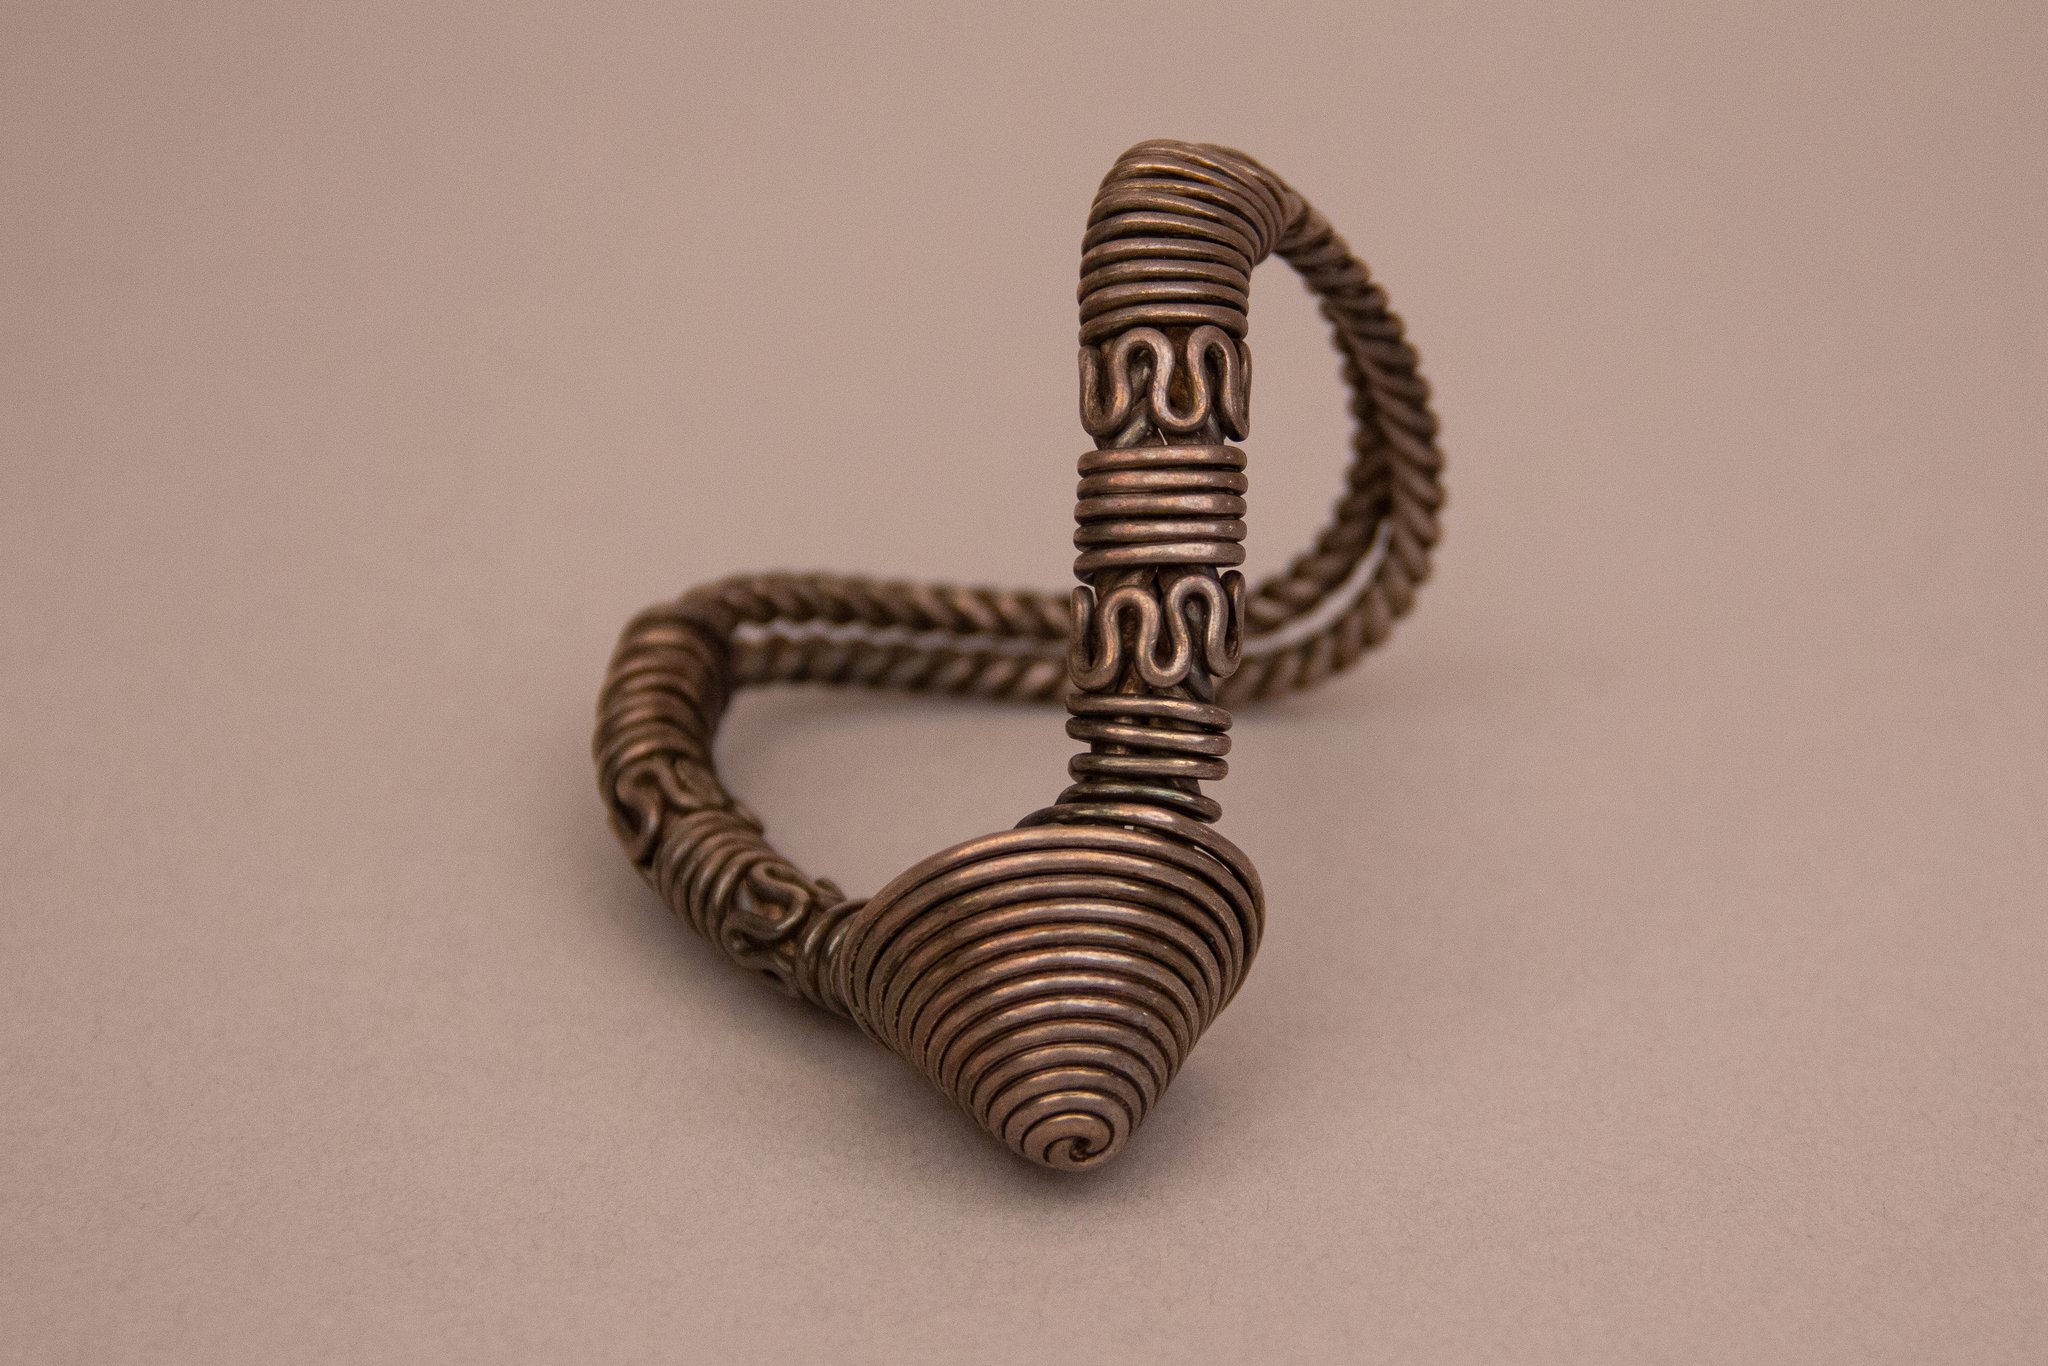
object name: armlet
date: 1801-1900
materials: silver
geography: india